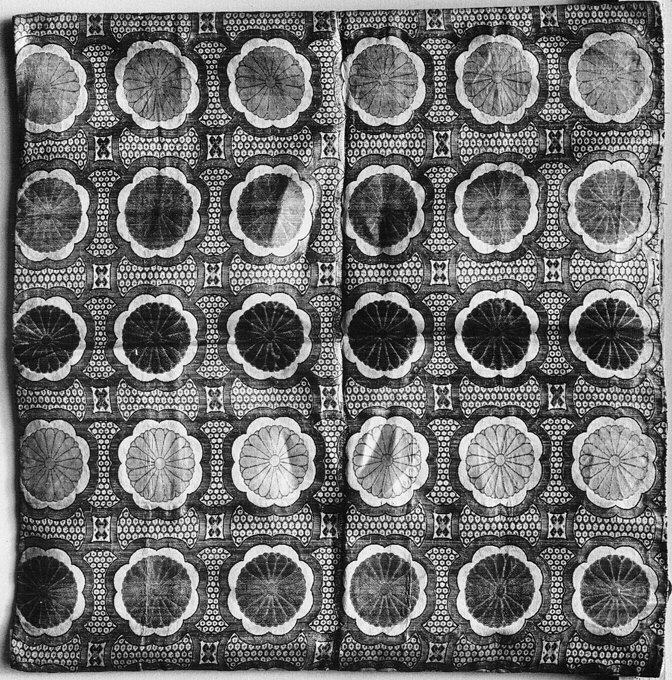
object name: altar cloth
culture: japanese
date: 1615-1868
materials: metal thread, silk